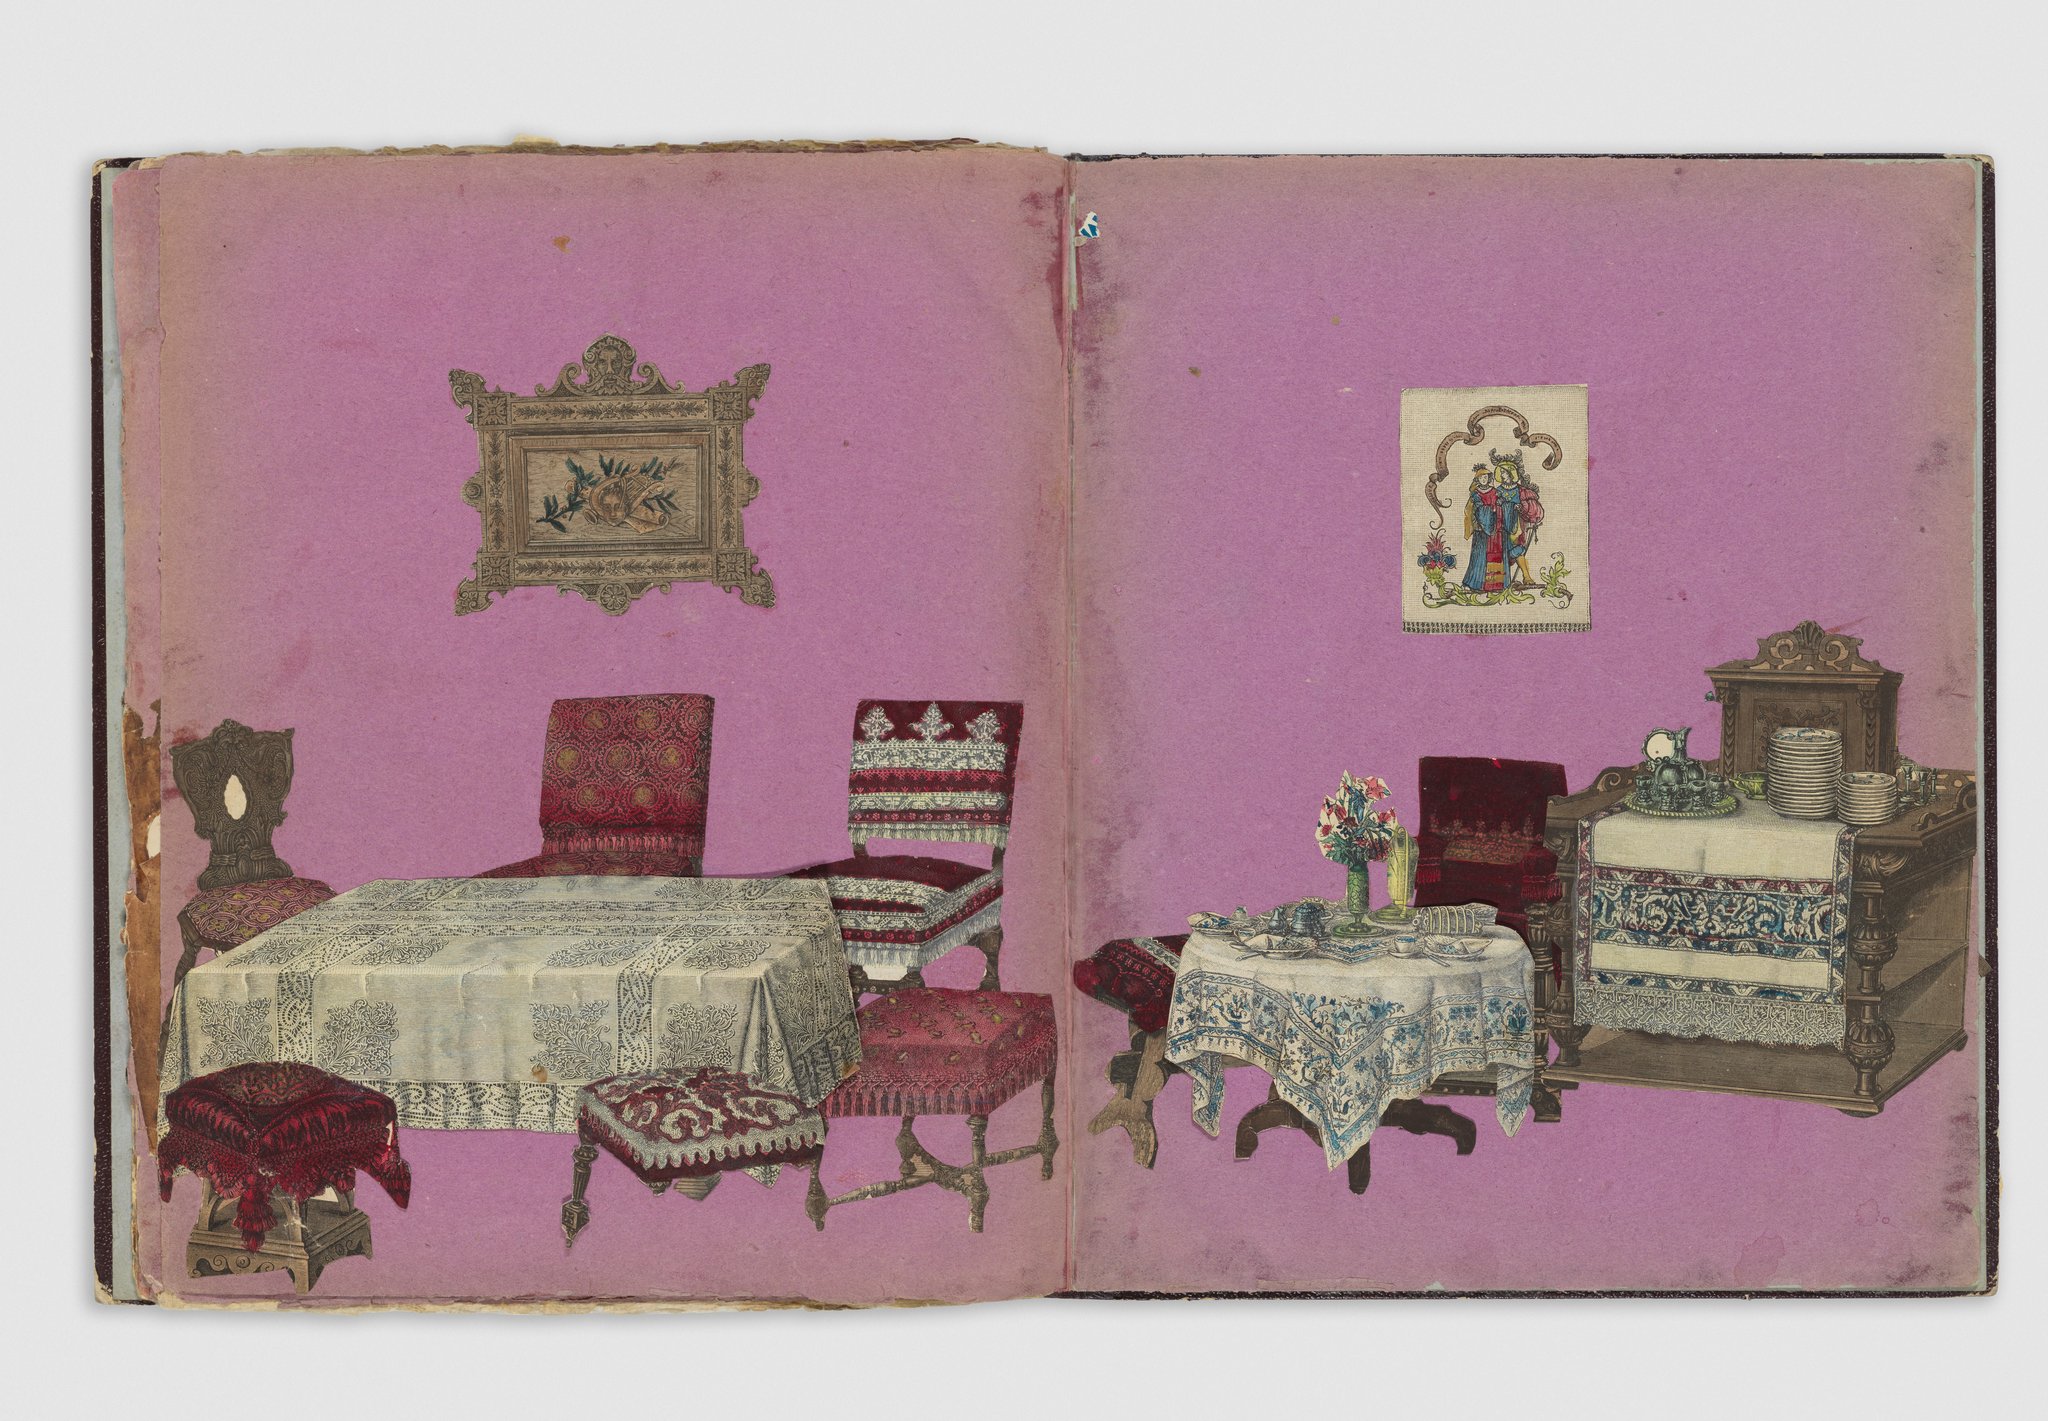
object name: album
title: Paper Doll Dining Room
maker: anonymous, german, 19th century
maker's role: artist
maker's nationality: german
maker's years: 1800-1899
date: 1883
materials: paper, wood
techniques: cutting, engraving, hand coloring, printing